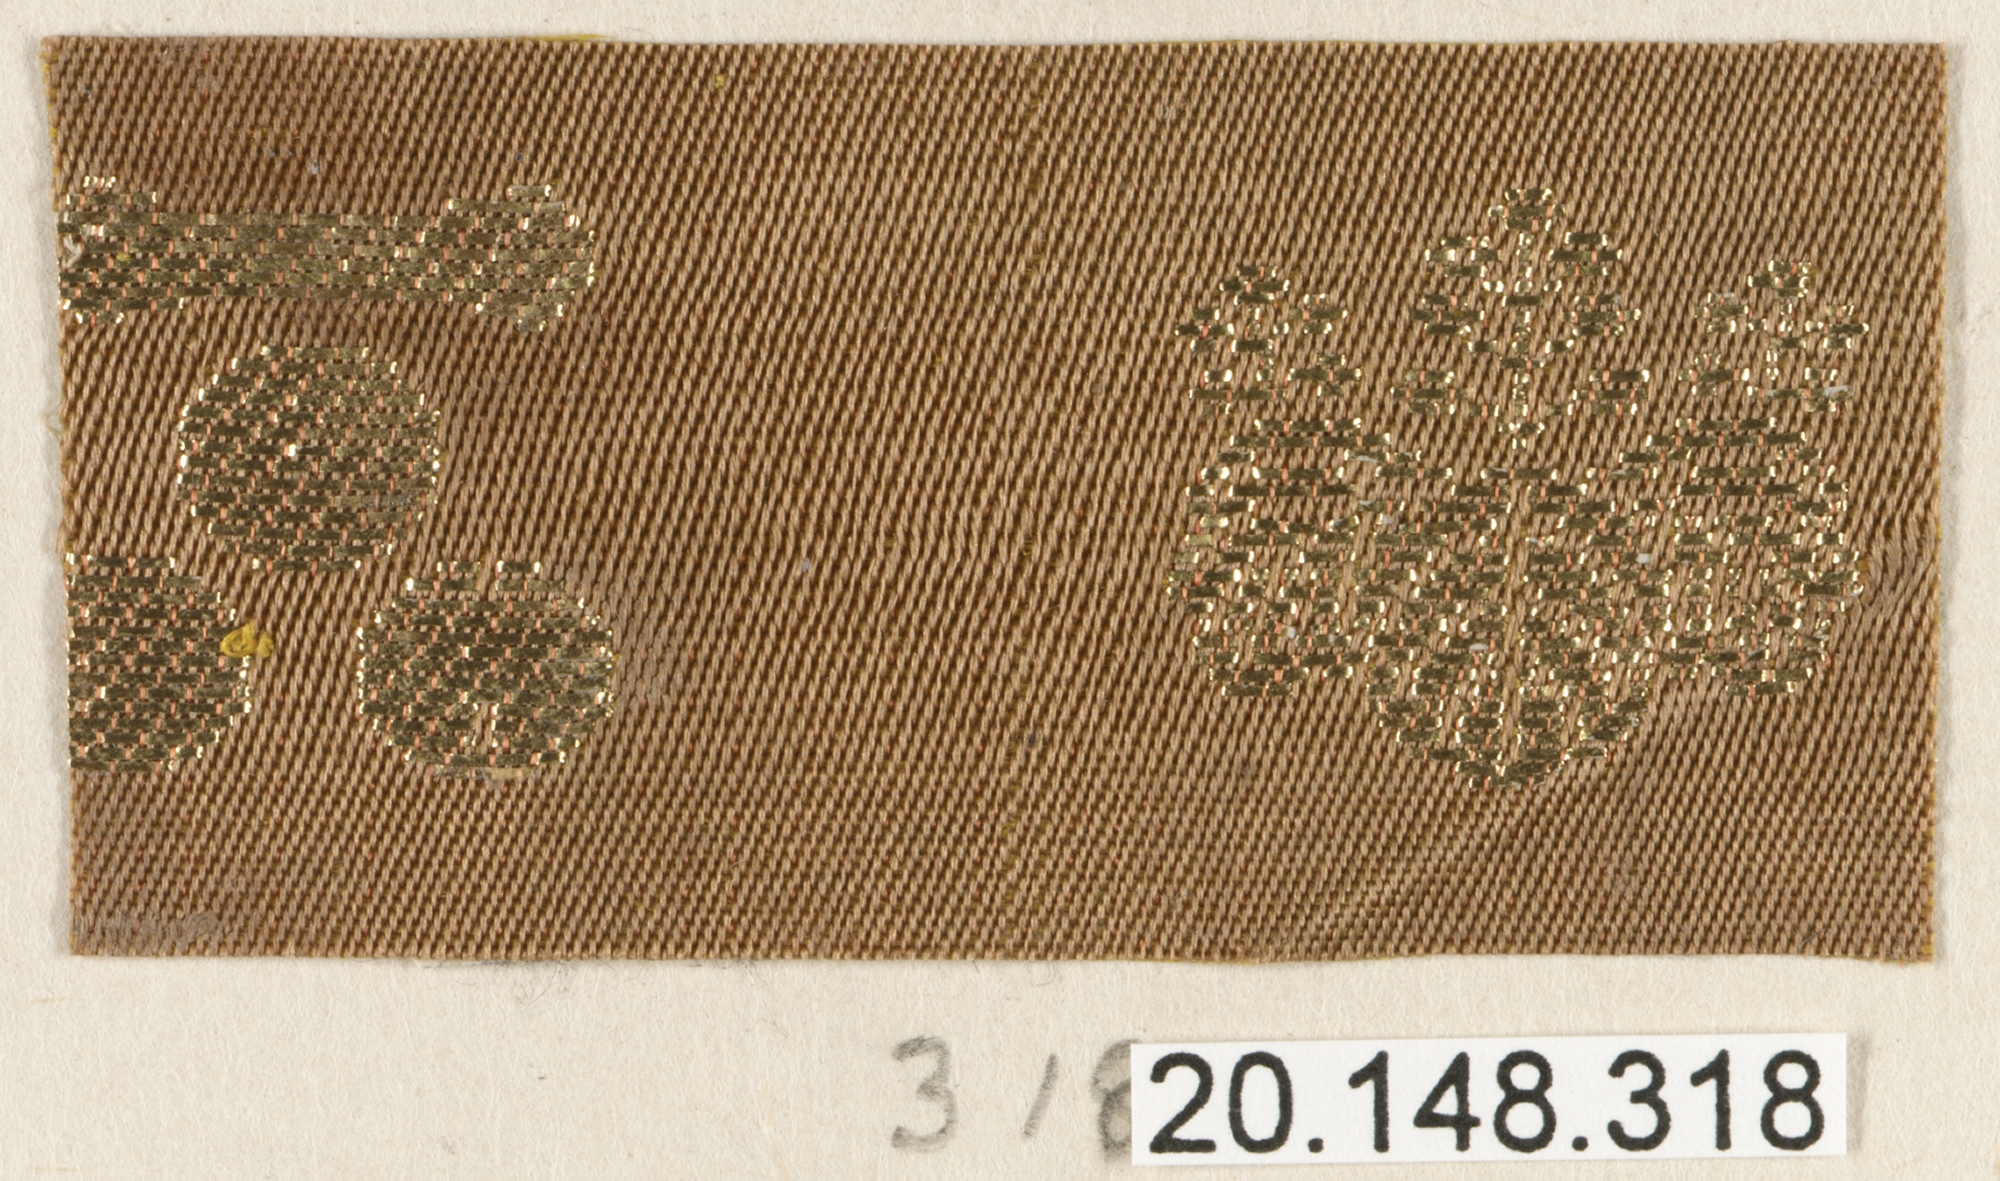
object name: piece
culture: japanese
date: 1601-1700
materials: silk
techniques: compound weave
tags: leaves